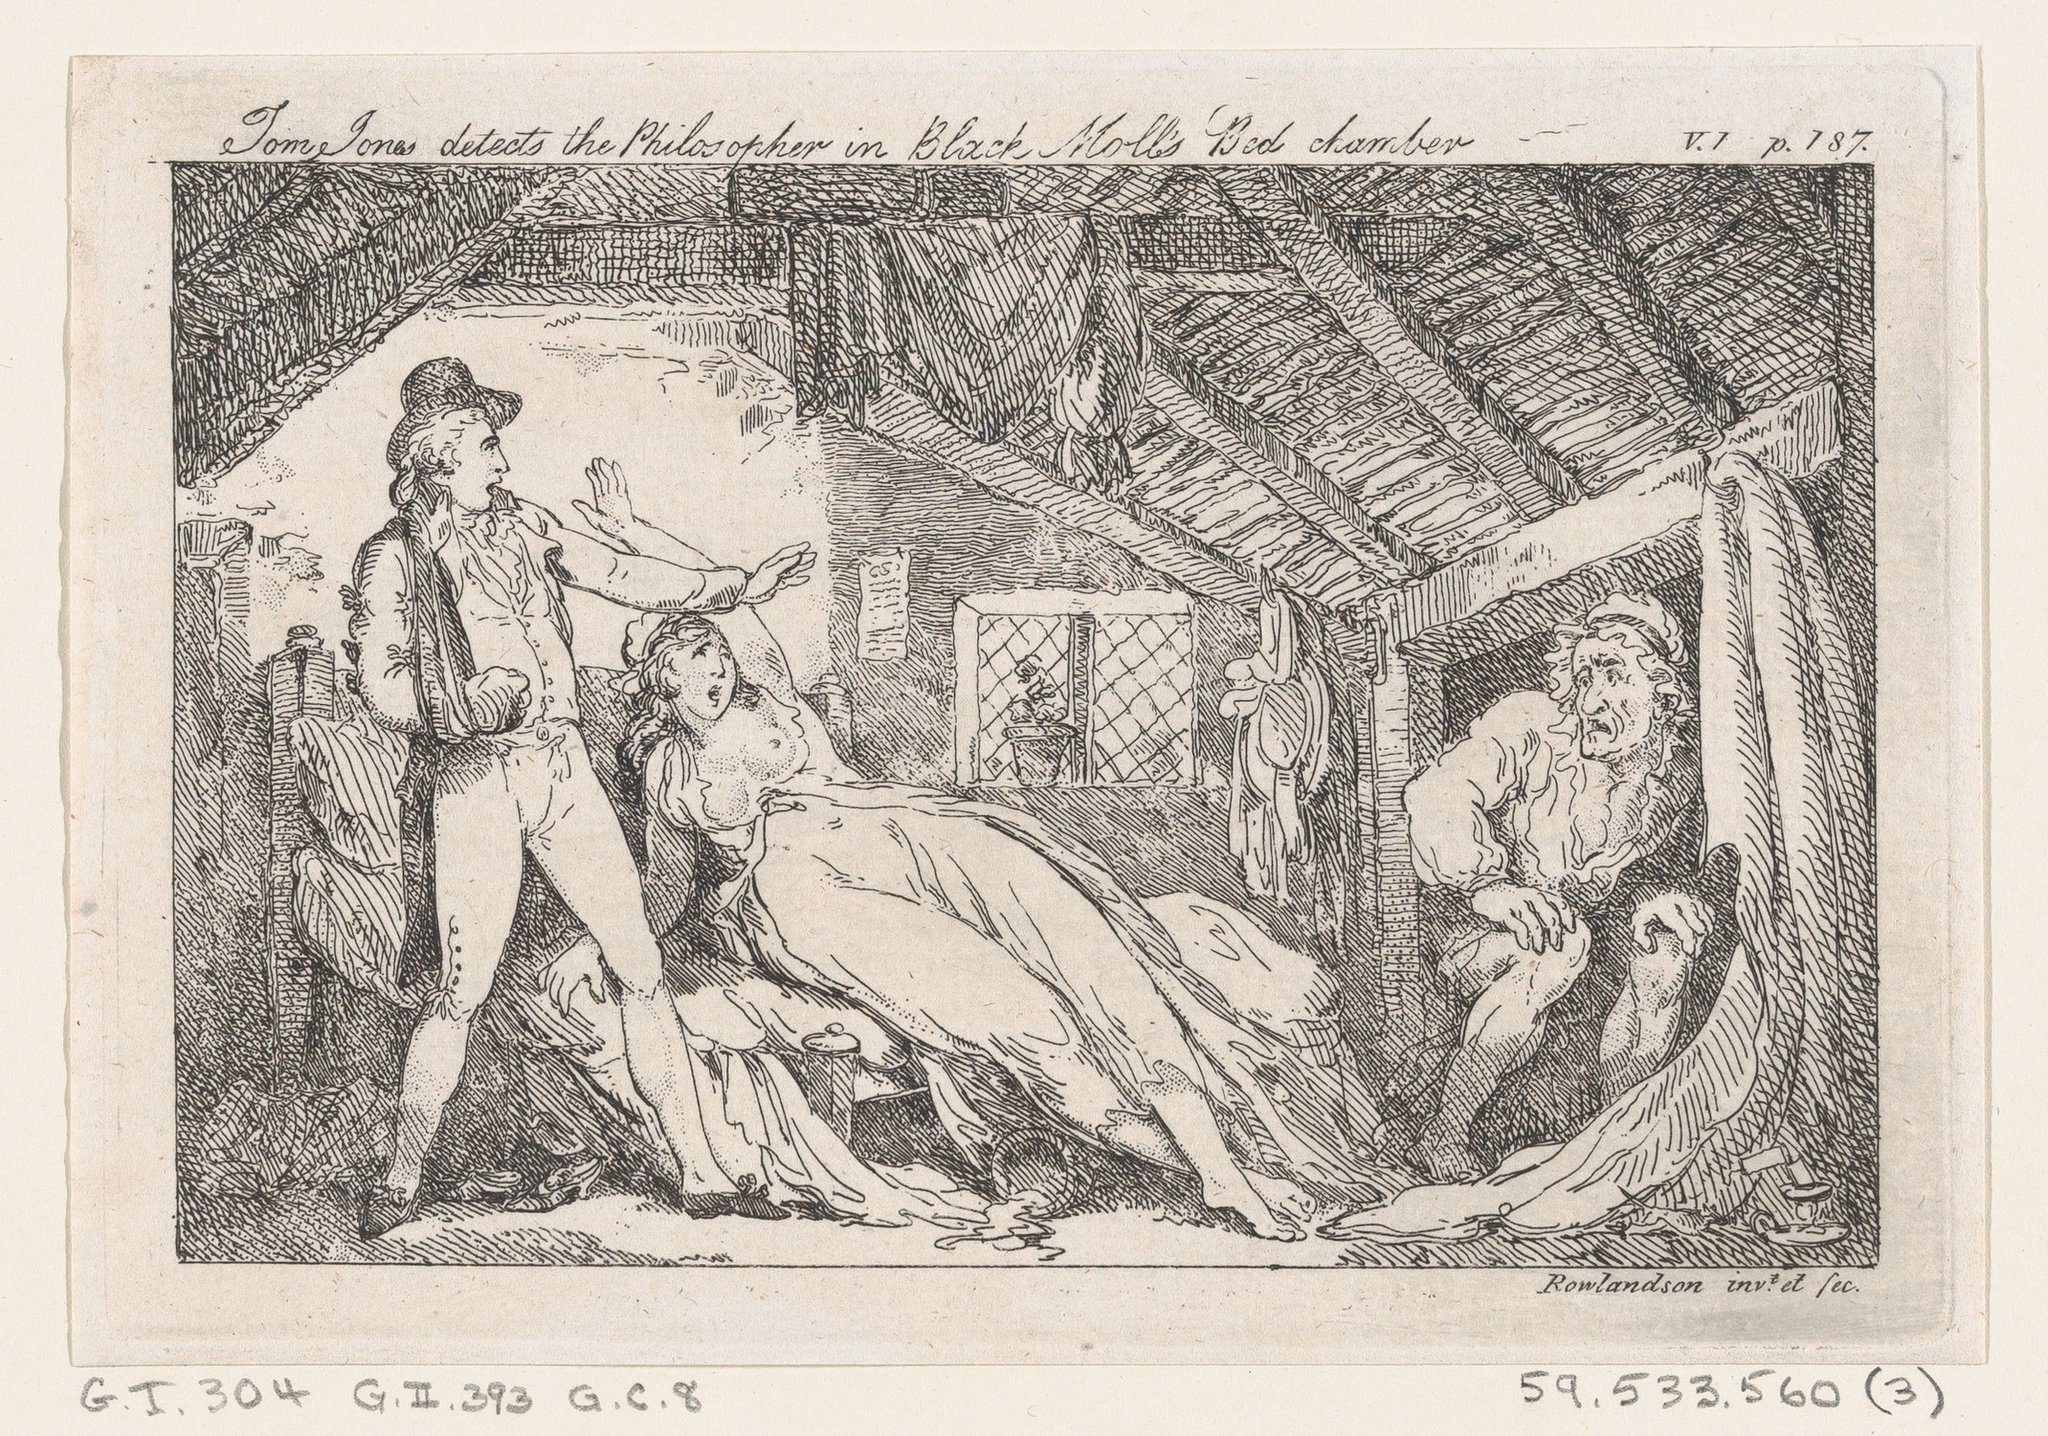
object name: print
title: Tom Jones detects the Philsopher in Black Molls Bed Chamber, "The History of Tom Jones, a Foundling"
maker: thomas rowlandson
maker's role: artist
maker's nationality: british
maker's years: 1757-1827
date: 1792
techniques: etching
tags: interiors,men,female nudes